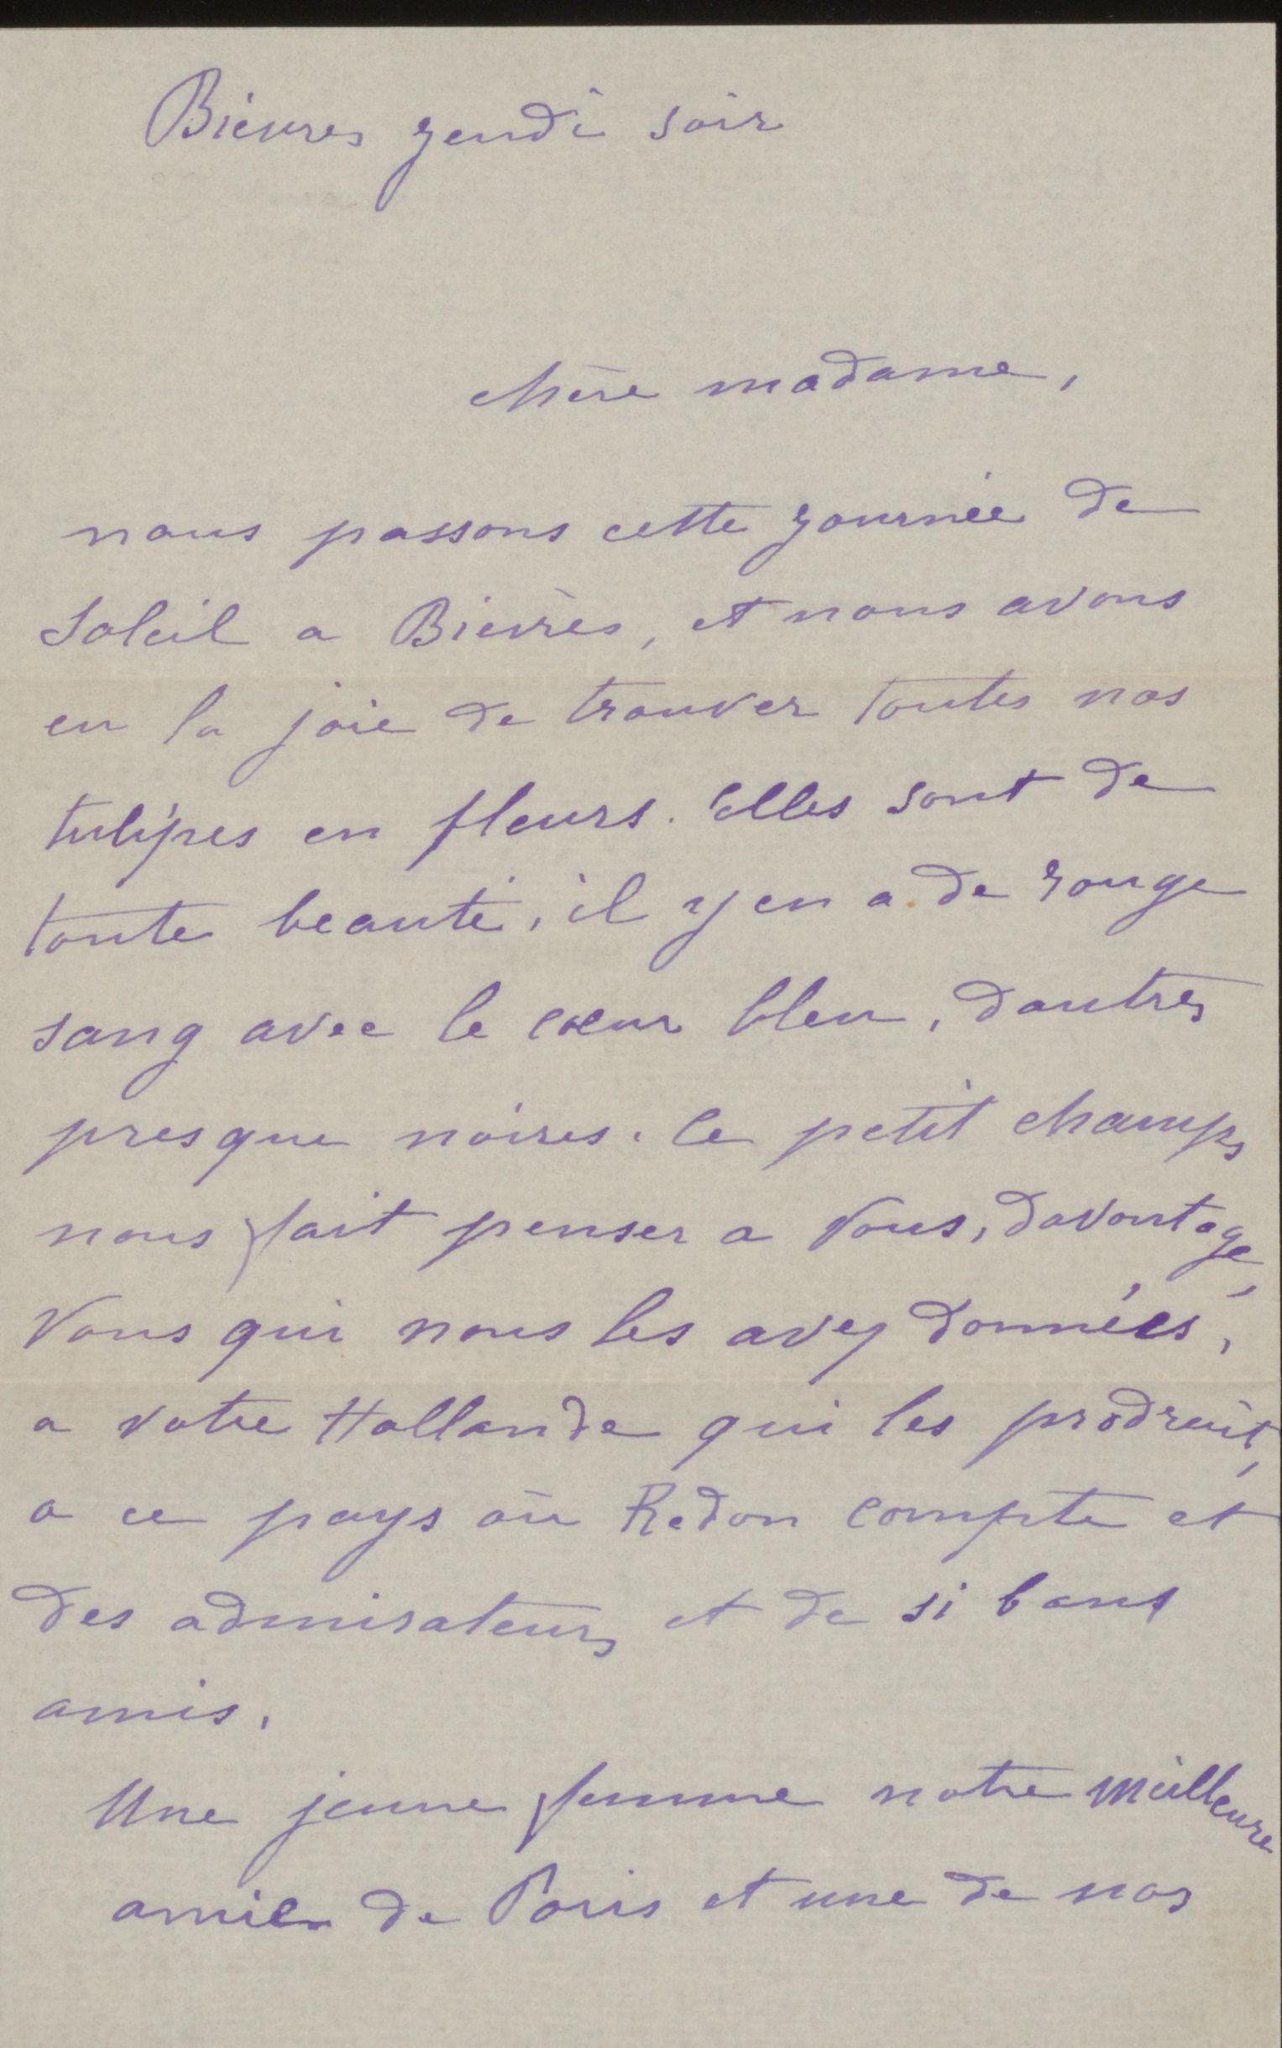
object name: letter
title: Brief aan Anne Marie Louise van der Linden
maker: camille redon-falte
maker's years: 1853-1923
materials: ink, paper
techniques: pen, writing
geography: bièvres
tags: paris, print maker, draughtsman, odilon redon, amsterdam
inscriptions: watermark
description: Brief behoort tot een album samengesteld door weduwe Françoise W.M. Barones van der Borch van Verwolde met afschriften van brieven met betrekking tot (de familie van) Odilon Redon. De brief werd bewaard op pagina 186.